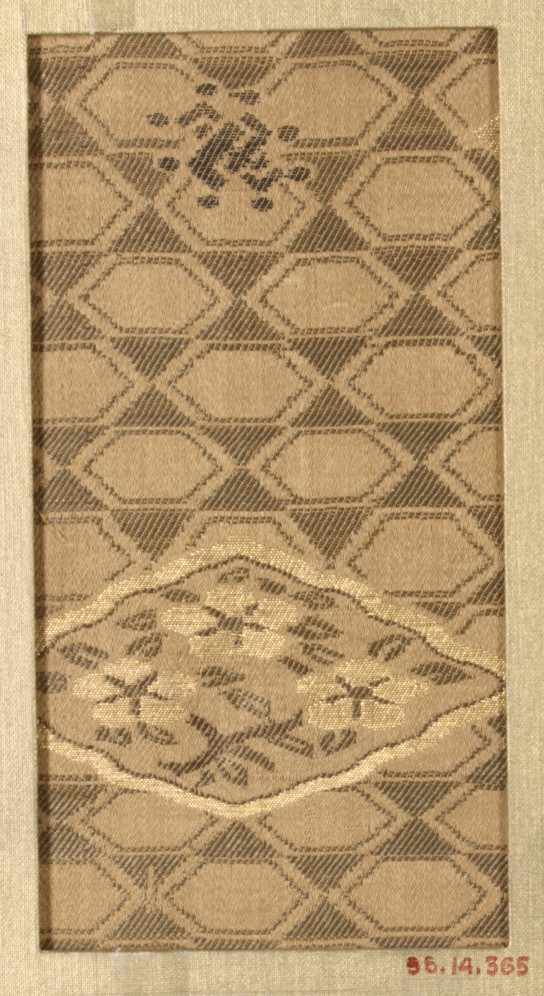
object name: piece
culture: japanese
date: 1701-1900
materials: silk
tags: flowers